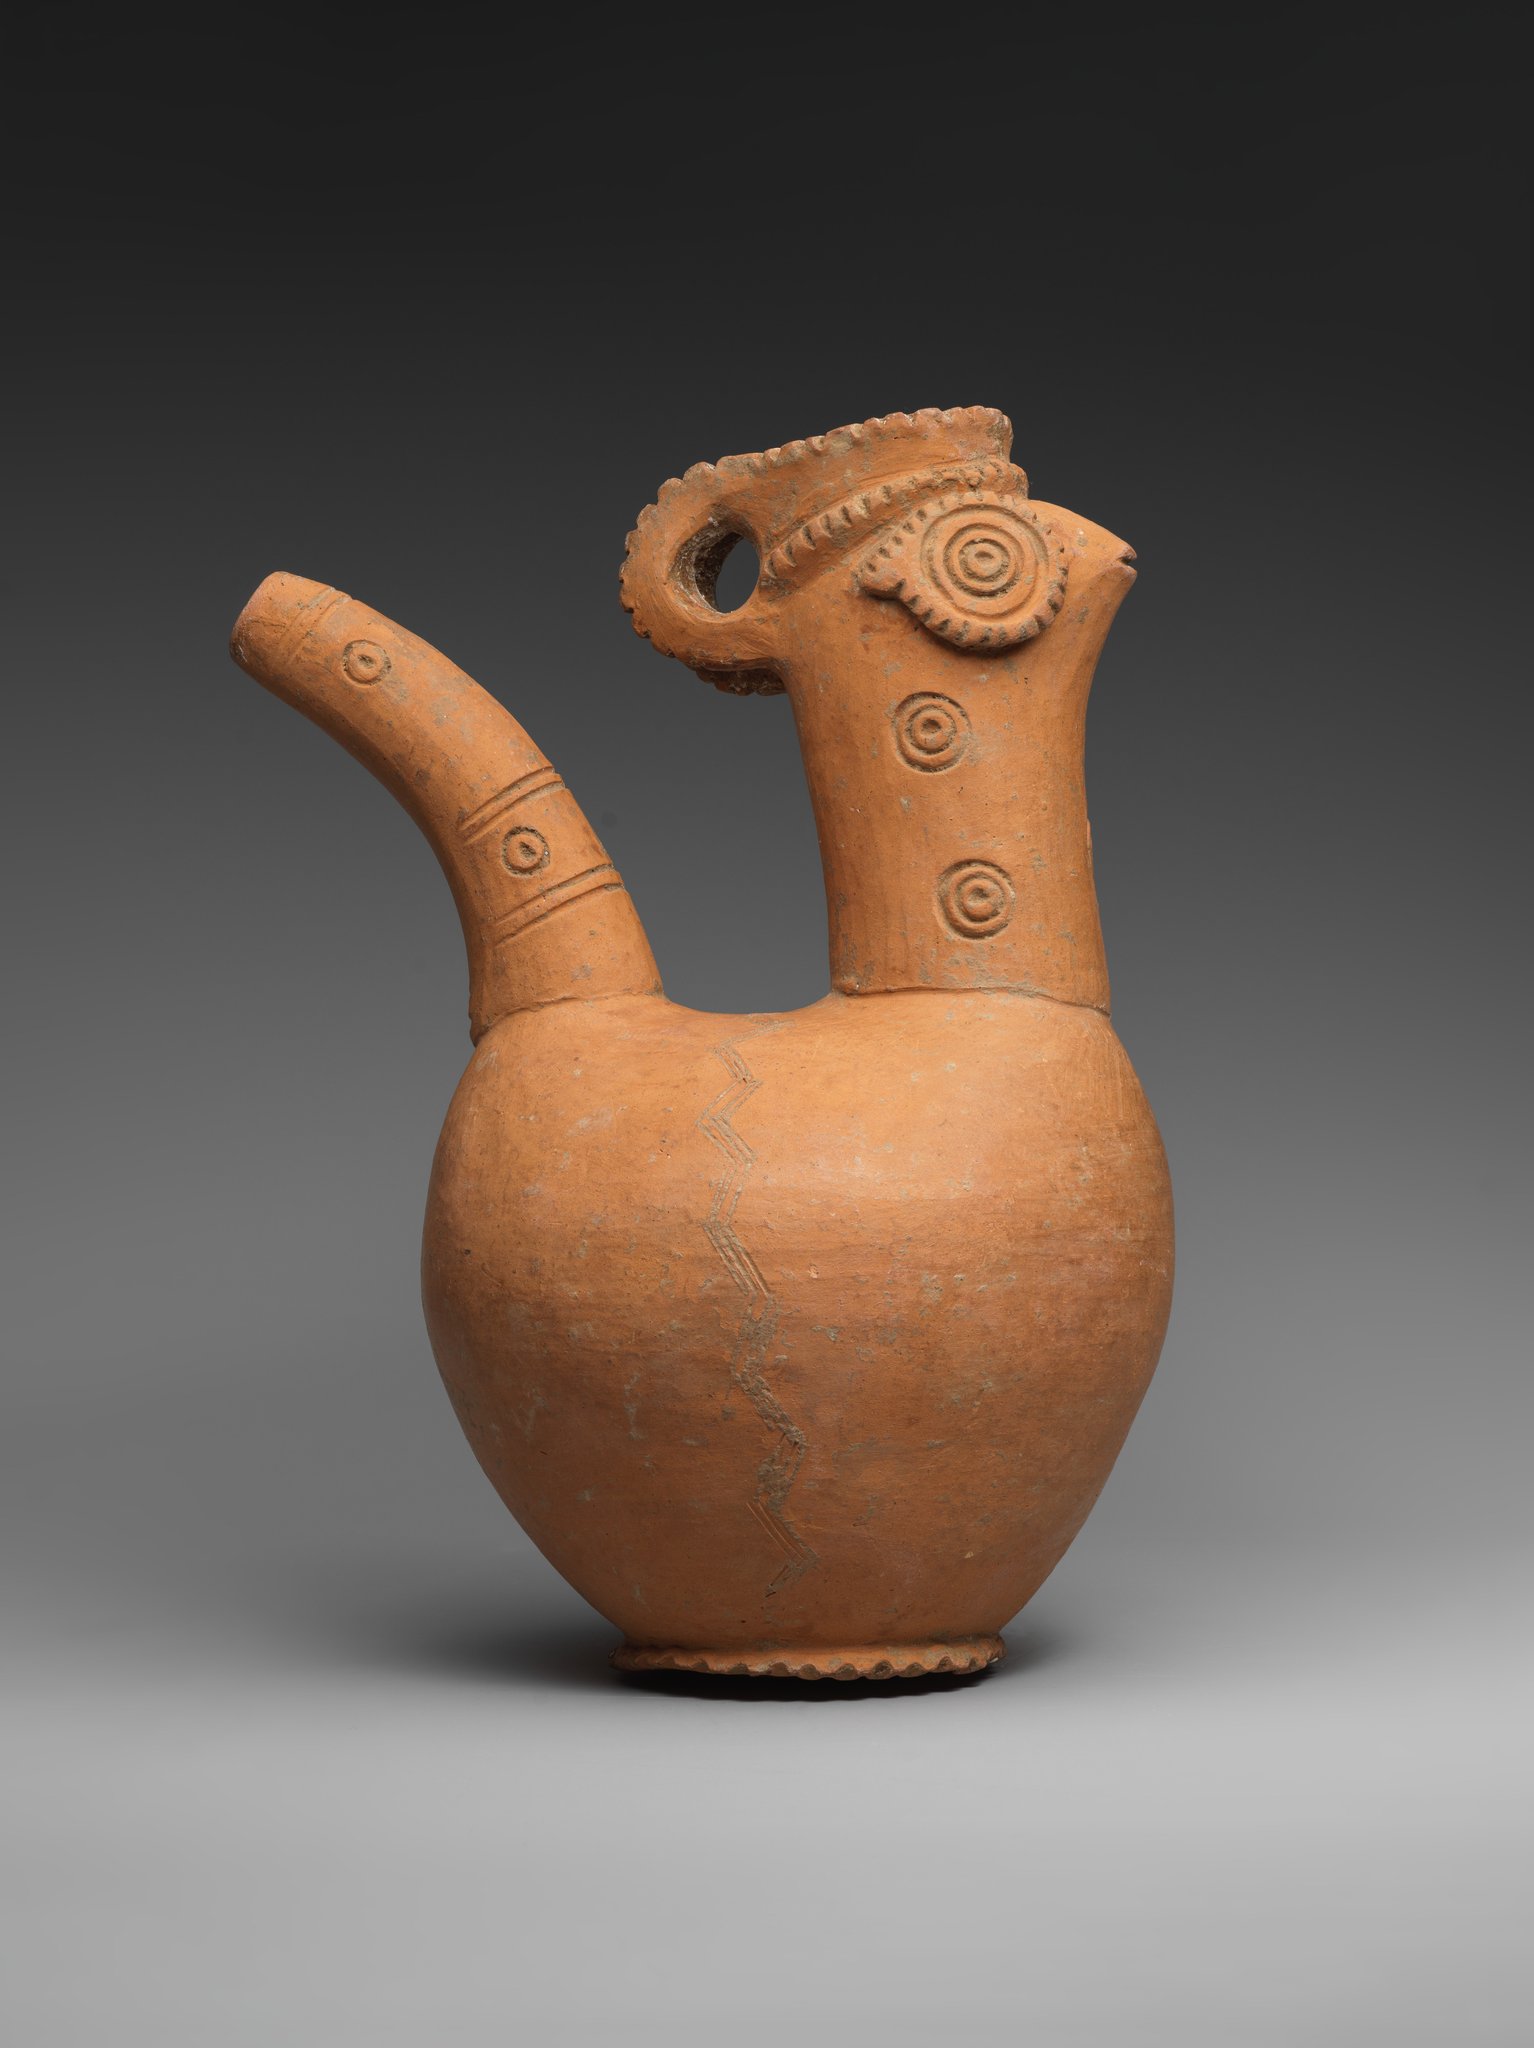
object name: vessel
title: Spouted vessel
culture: iranian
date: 900 BCE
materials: ceramic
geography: northwestern iran